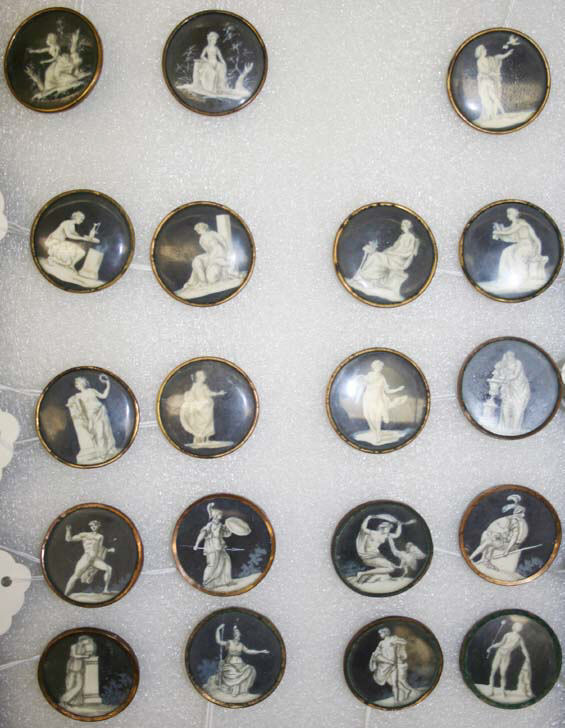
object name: button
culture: french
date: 1775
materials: glass, ivory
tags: human figures